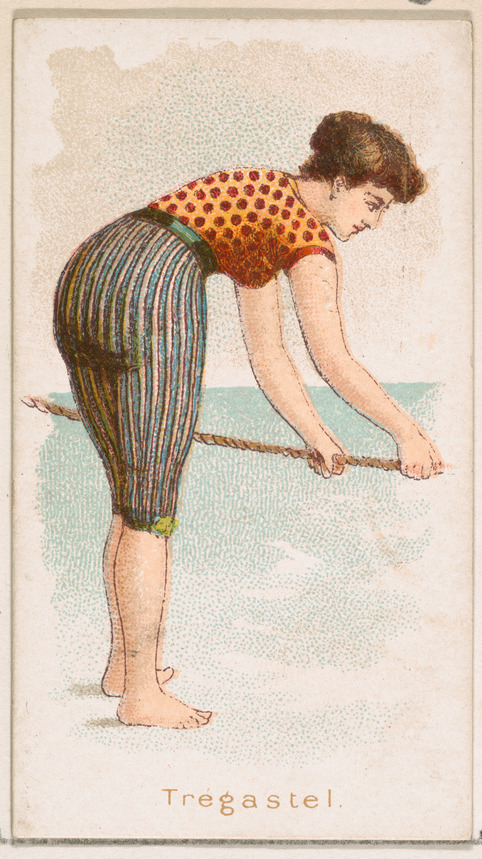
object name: print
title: Tregastel, from the Fancy Bathers series (N187) issued by Wm. S. Kimball & Co.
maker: william s. kimball & company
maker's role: publisher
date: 1889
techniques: color lithograph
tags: profiles,women